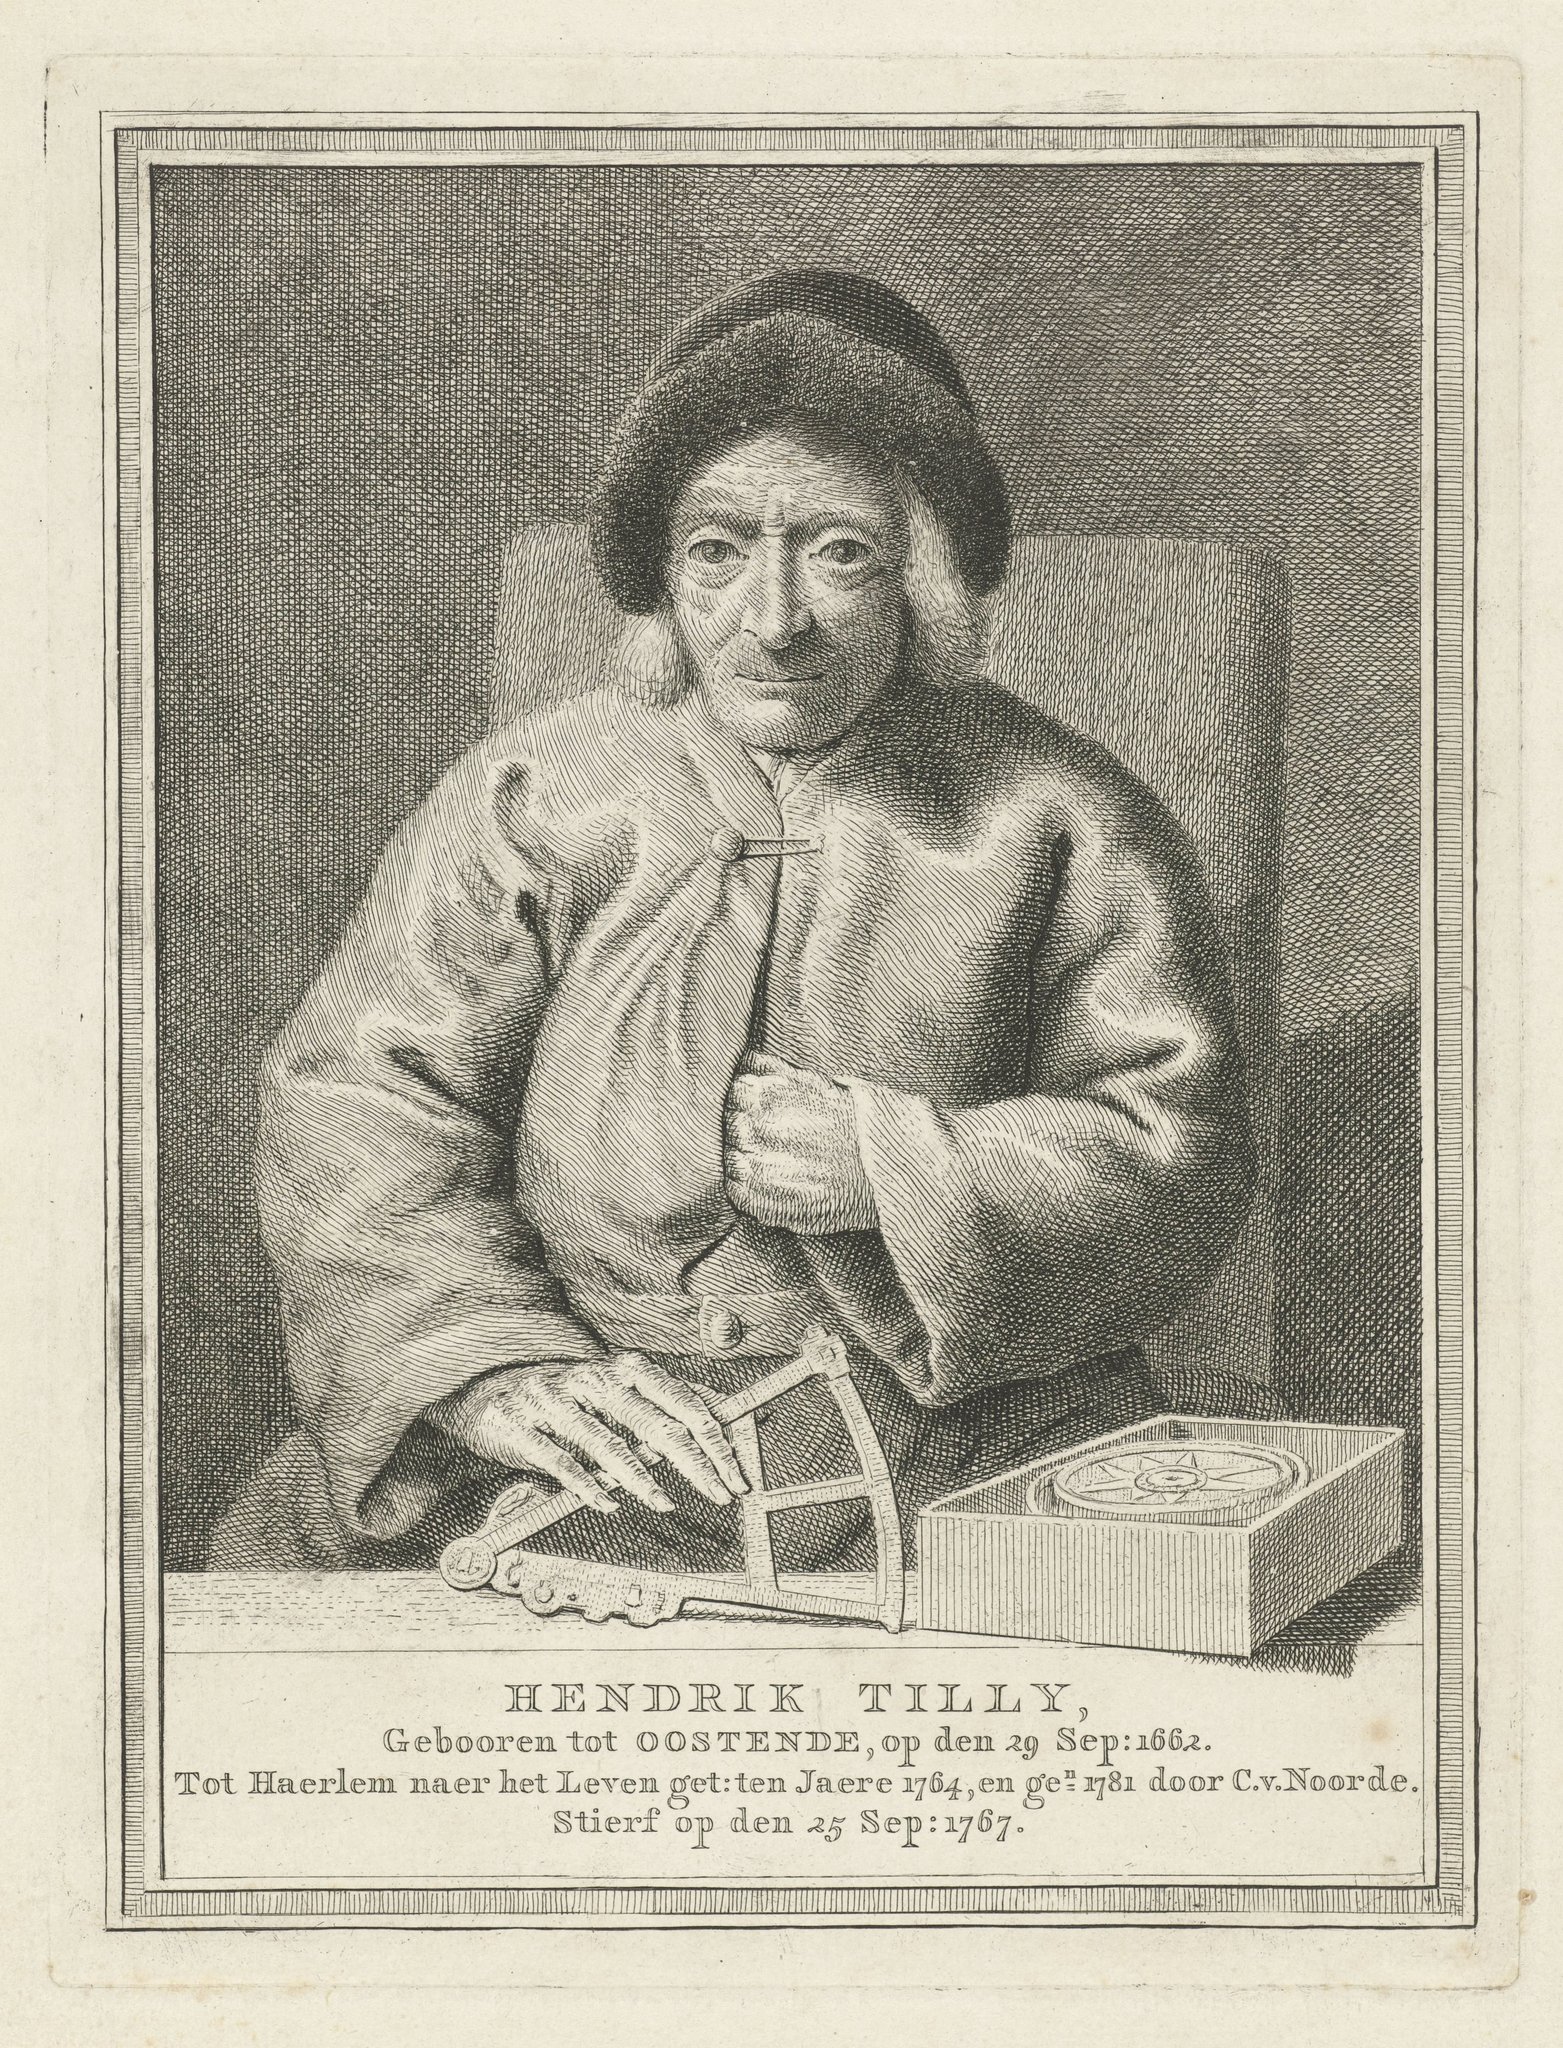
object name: print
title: Portret van Hendrik Tilly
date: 1767-1845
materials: paper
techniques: engraving, etching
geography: haarlem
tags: haarlem, compass, quadrant, sextant, octant (nautical instruments)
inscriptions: collector's mark: Lugt 2228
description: Portret van Hendrik Tilly op 102-jarige leeftijd. Zijn hand rust op een octant. Daarnaast ligt een kompas. Tilly woonde in het Aalmoezeniershuis van Haarlem en stierf op 105-jarige leeftijd.